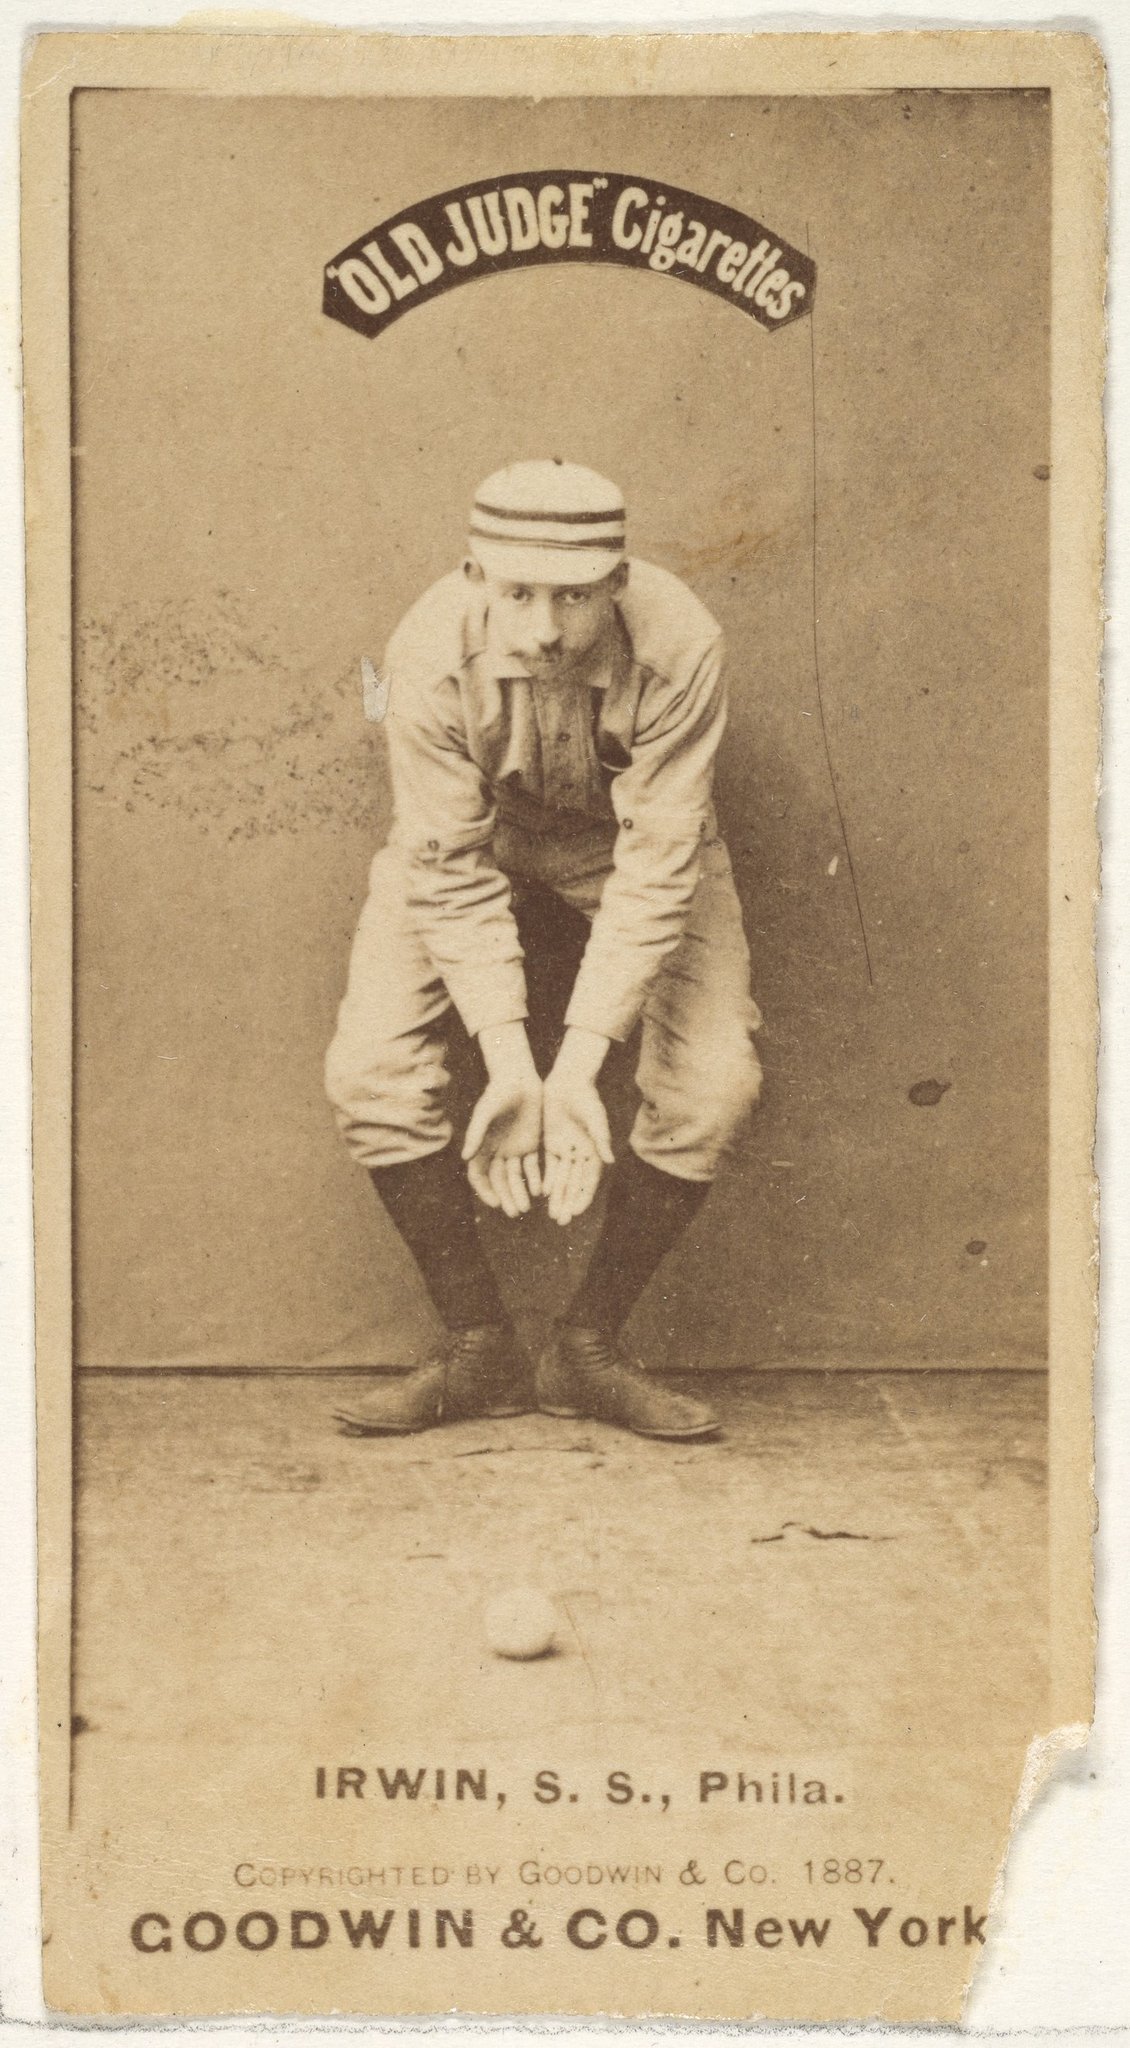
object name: baseball card, photograph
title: Arthur Albert "Doc" Irwin, Shortstop, Philadelphia, from the Old Judge series (N172) for Old Judge Cigarettes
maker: goodwin & company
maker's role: publisher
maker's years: 1850-1950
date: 1887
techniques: albumen silver print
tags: men,portraits,baseball,athletes